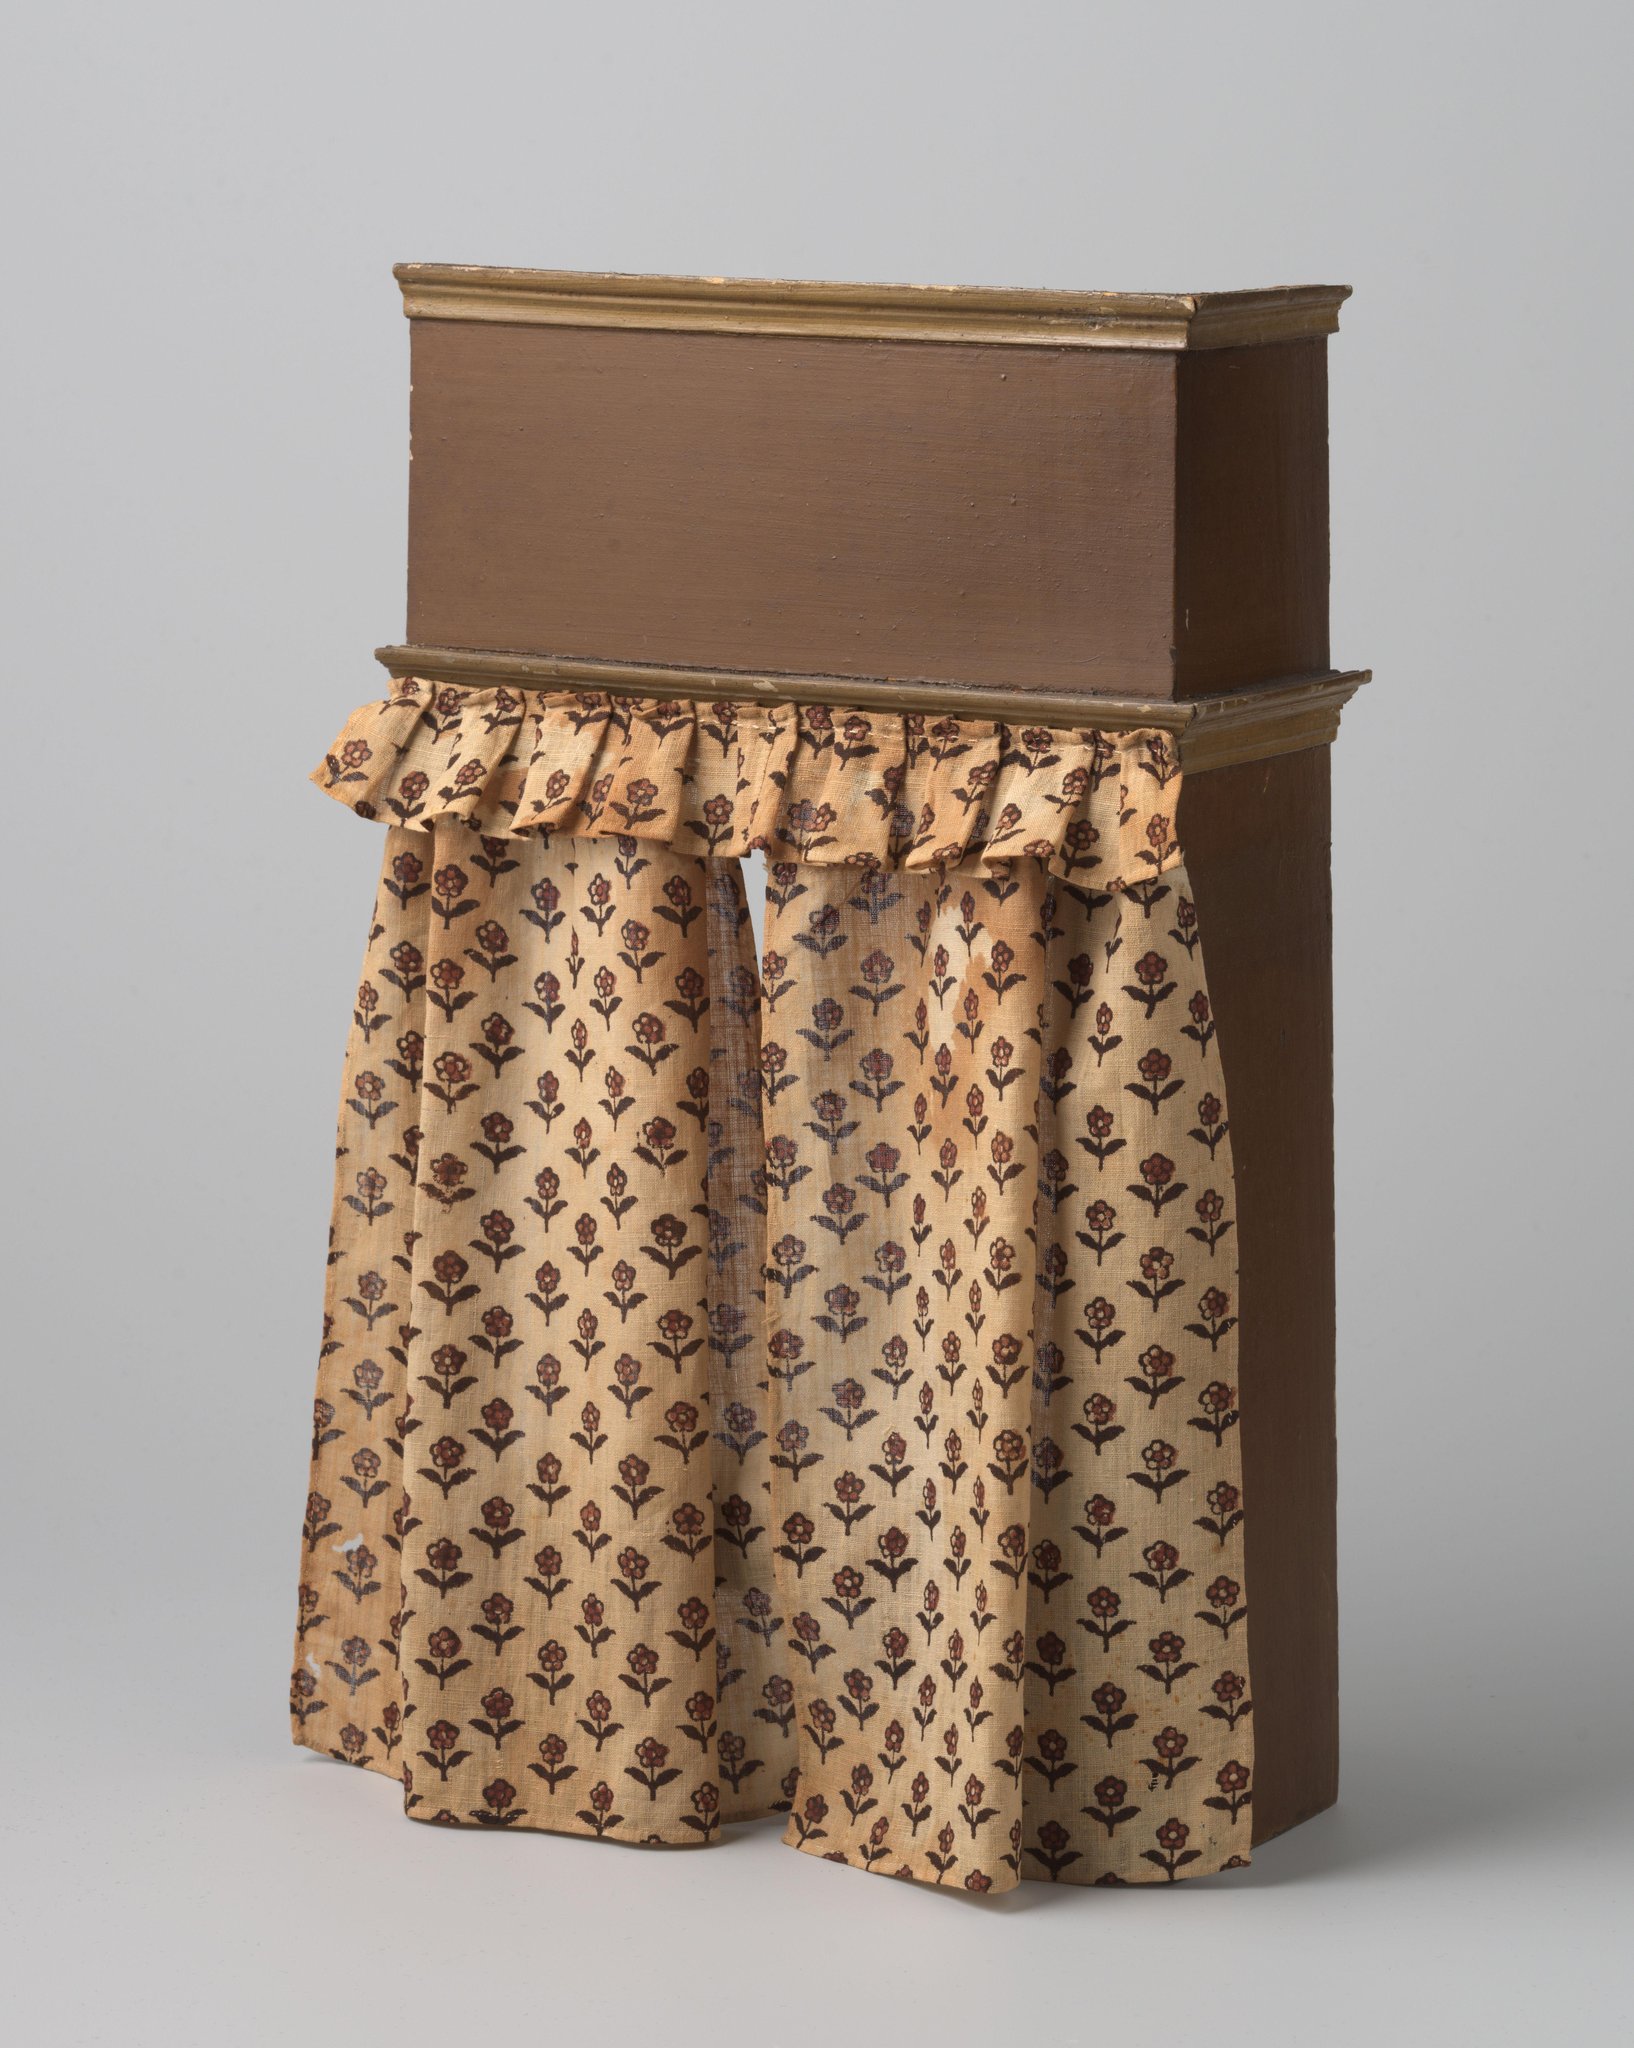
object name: rabat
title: Rabat (val) van bedstede, van bedrukte katoen en met vastgeregen plooien.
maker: Anonymous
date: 1690-1710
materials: cotton, linen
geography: india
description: Rabat (val) voor een bedstede, vervaardigd van bedrukte katoen met verspringend motief van bloem op steeltje, zwart rood op witte achtergrond. Val met vastgeregen plooien wordt met een paar steken of spelden vastgezet op bandje boven de bedstede opening.